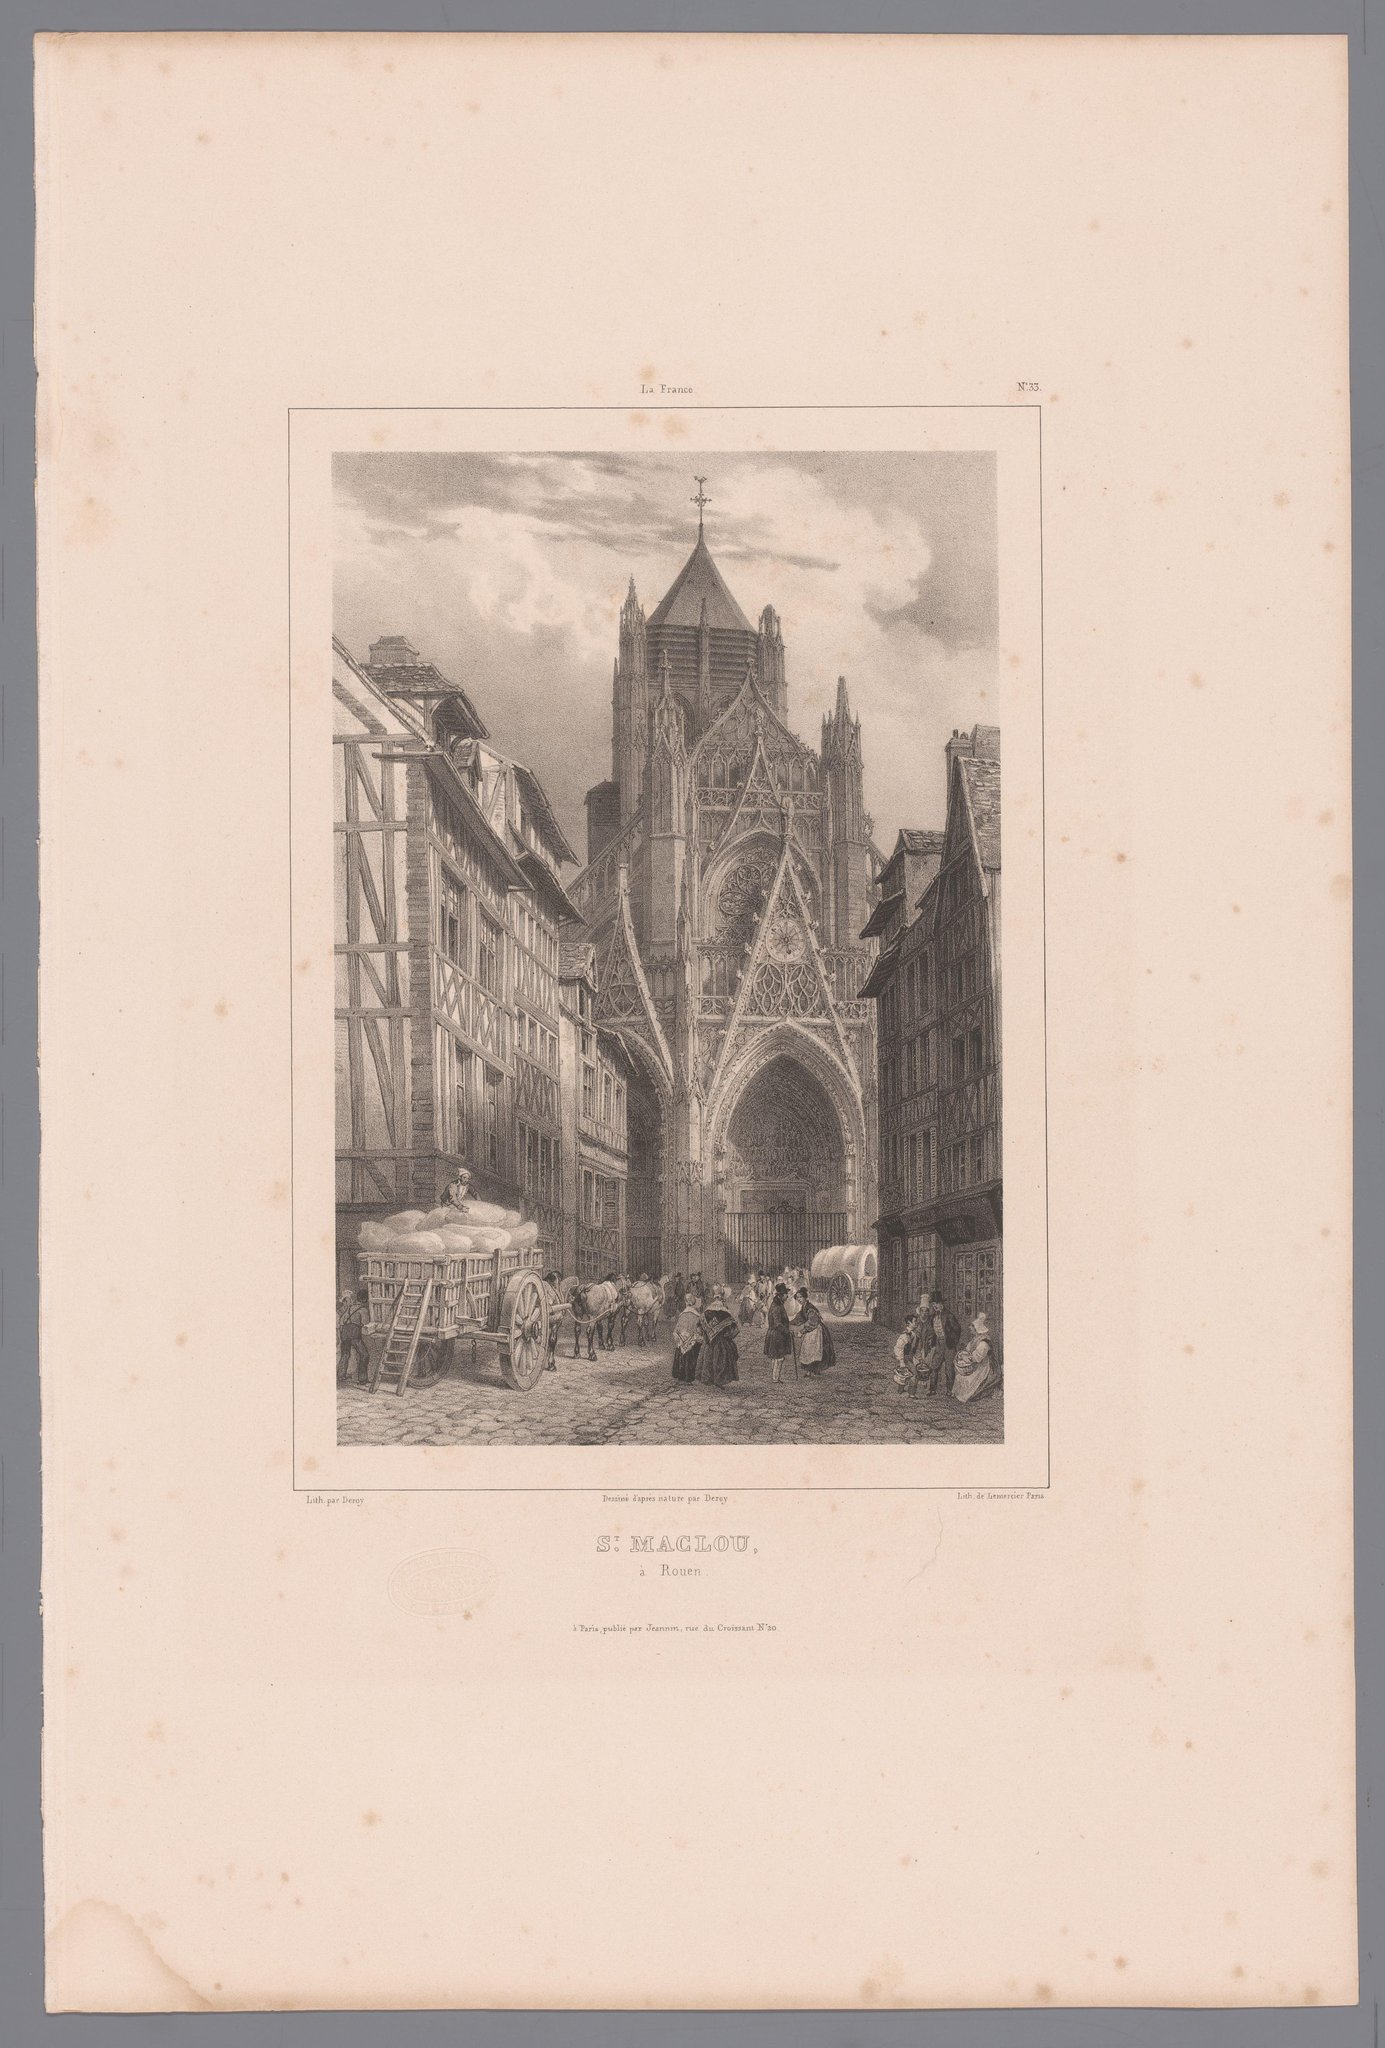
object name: print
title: La France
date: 1834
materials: paper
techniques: lithograph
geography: paris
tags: church (exterior)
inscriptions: collector's mark: Lugt 2228a, check stamp: Lugt 1397c